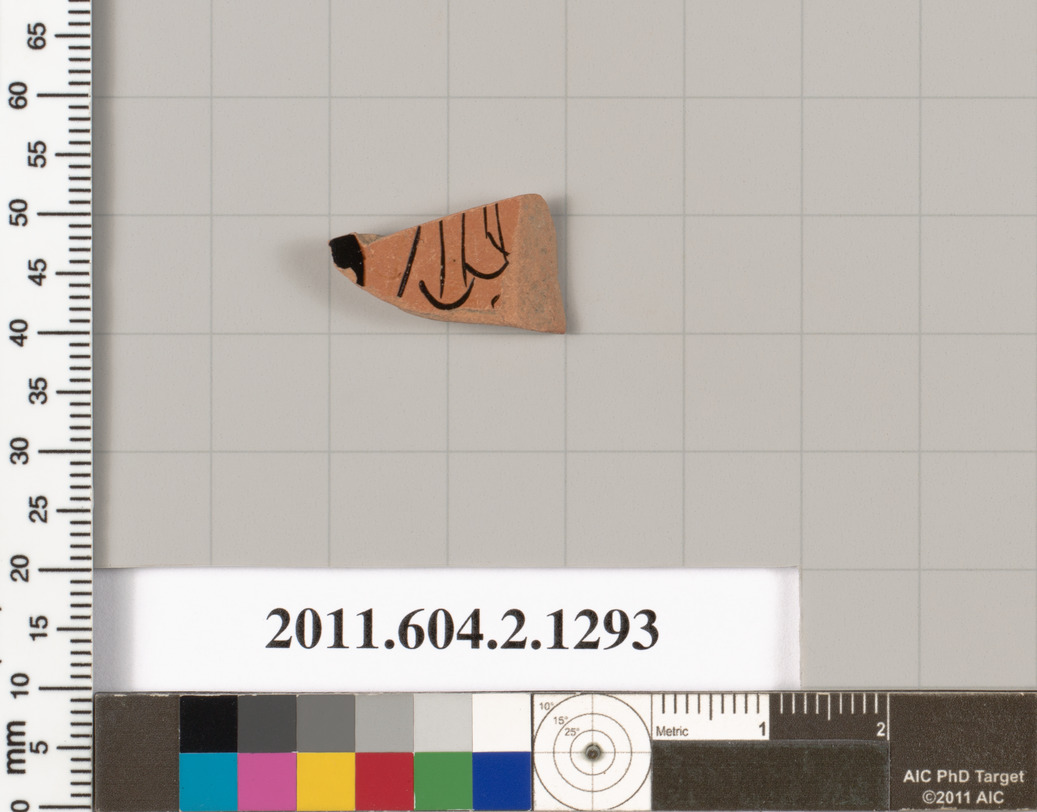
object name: skyphos fragment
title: Terracotta fragment of a skyphos (deep drinking cup)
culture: greek, attic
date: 475-451 BCE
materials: terracotta